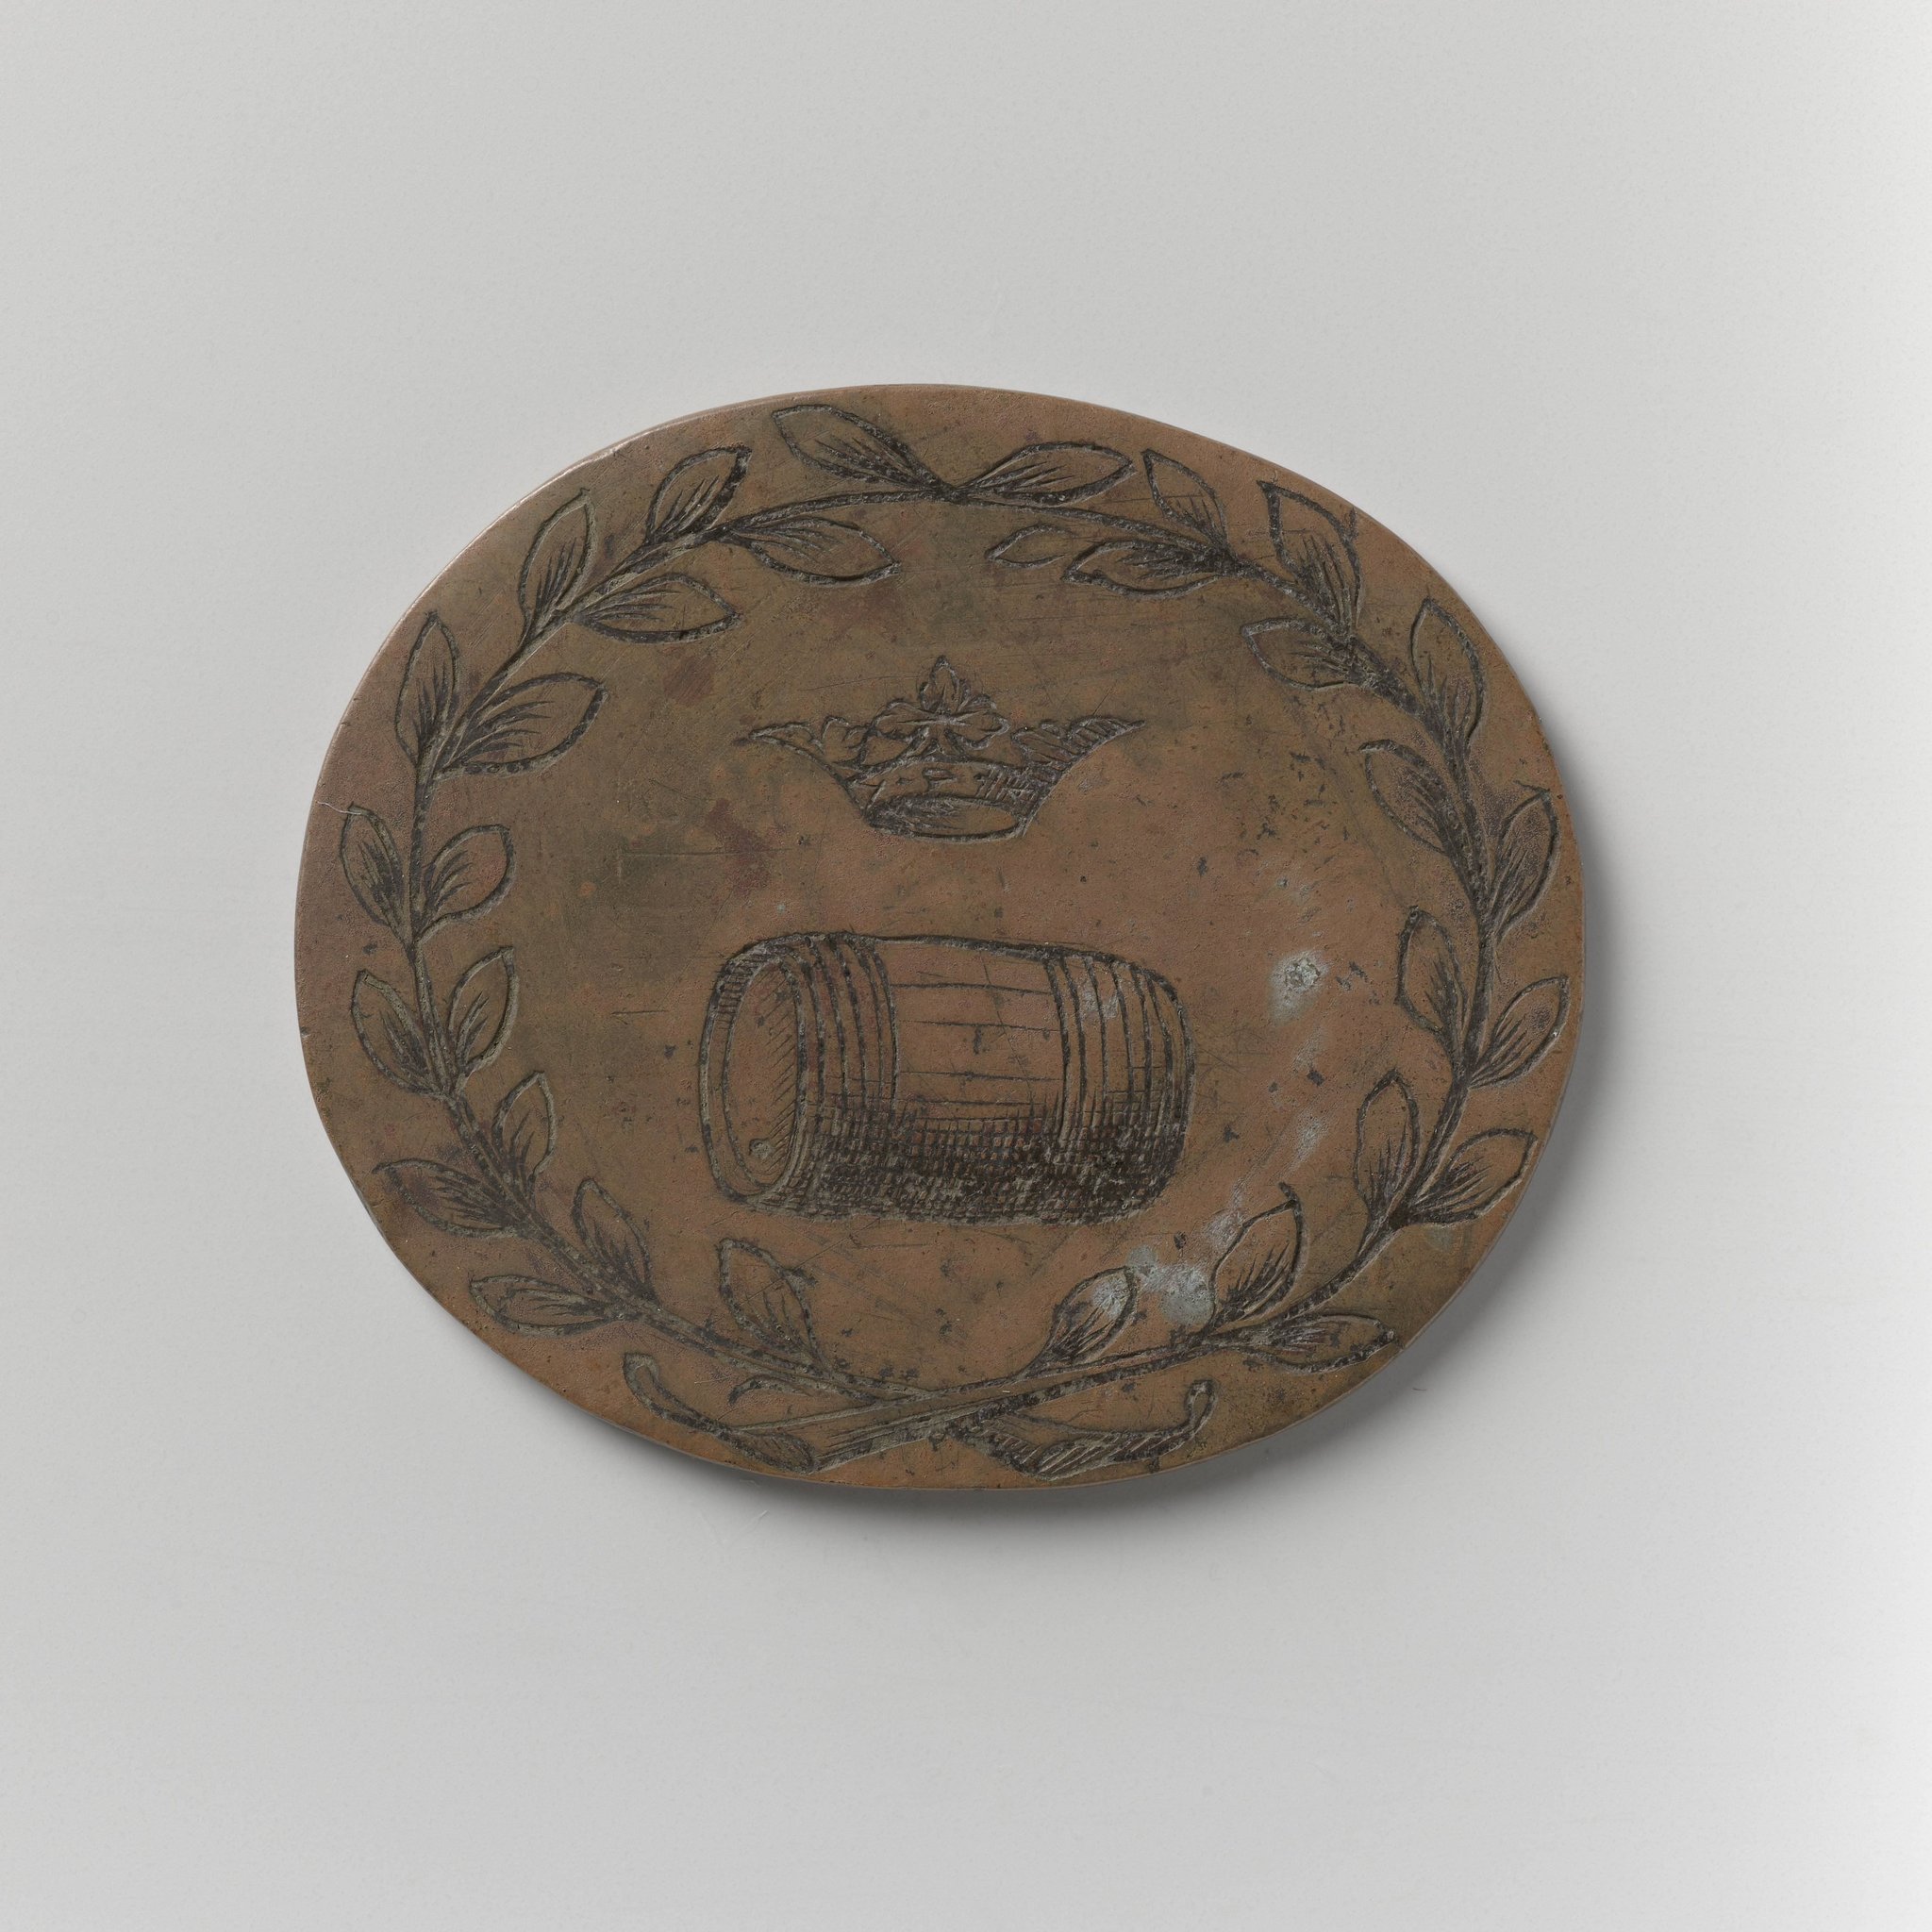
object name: medal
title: Bierbeschooiersgilde van Amsterdam, gildepenning van Willem Koenders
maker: Anonymous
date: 1600-1800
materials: copper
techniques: engraving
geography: amsterdam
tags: amsterdam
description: Koperen ovale gildepenning. Voorzijde: gekroond vat binnen bladerkrans. Keerzijde: opschrift binnen bladerkrans